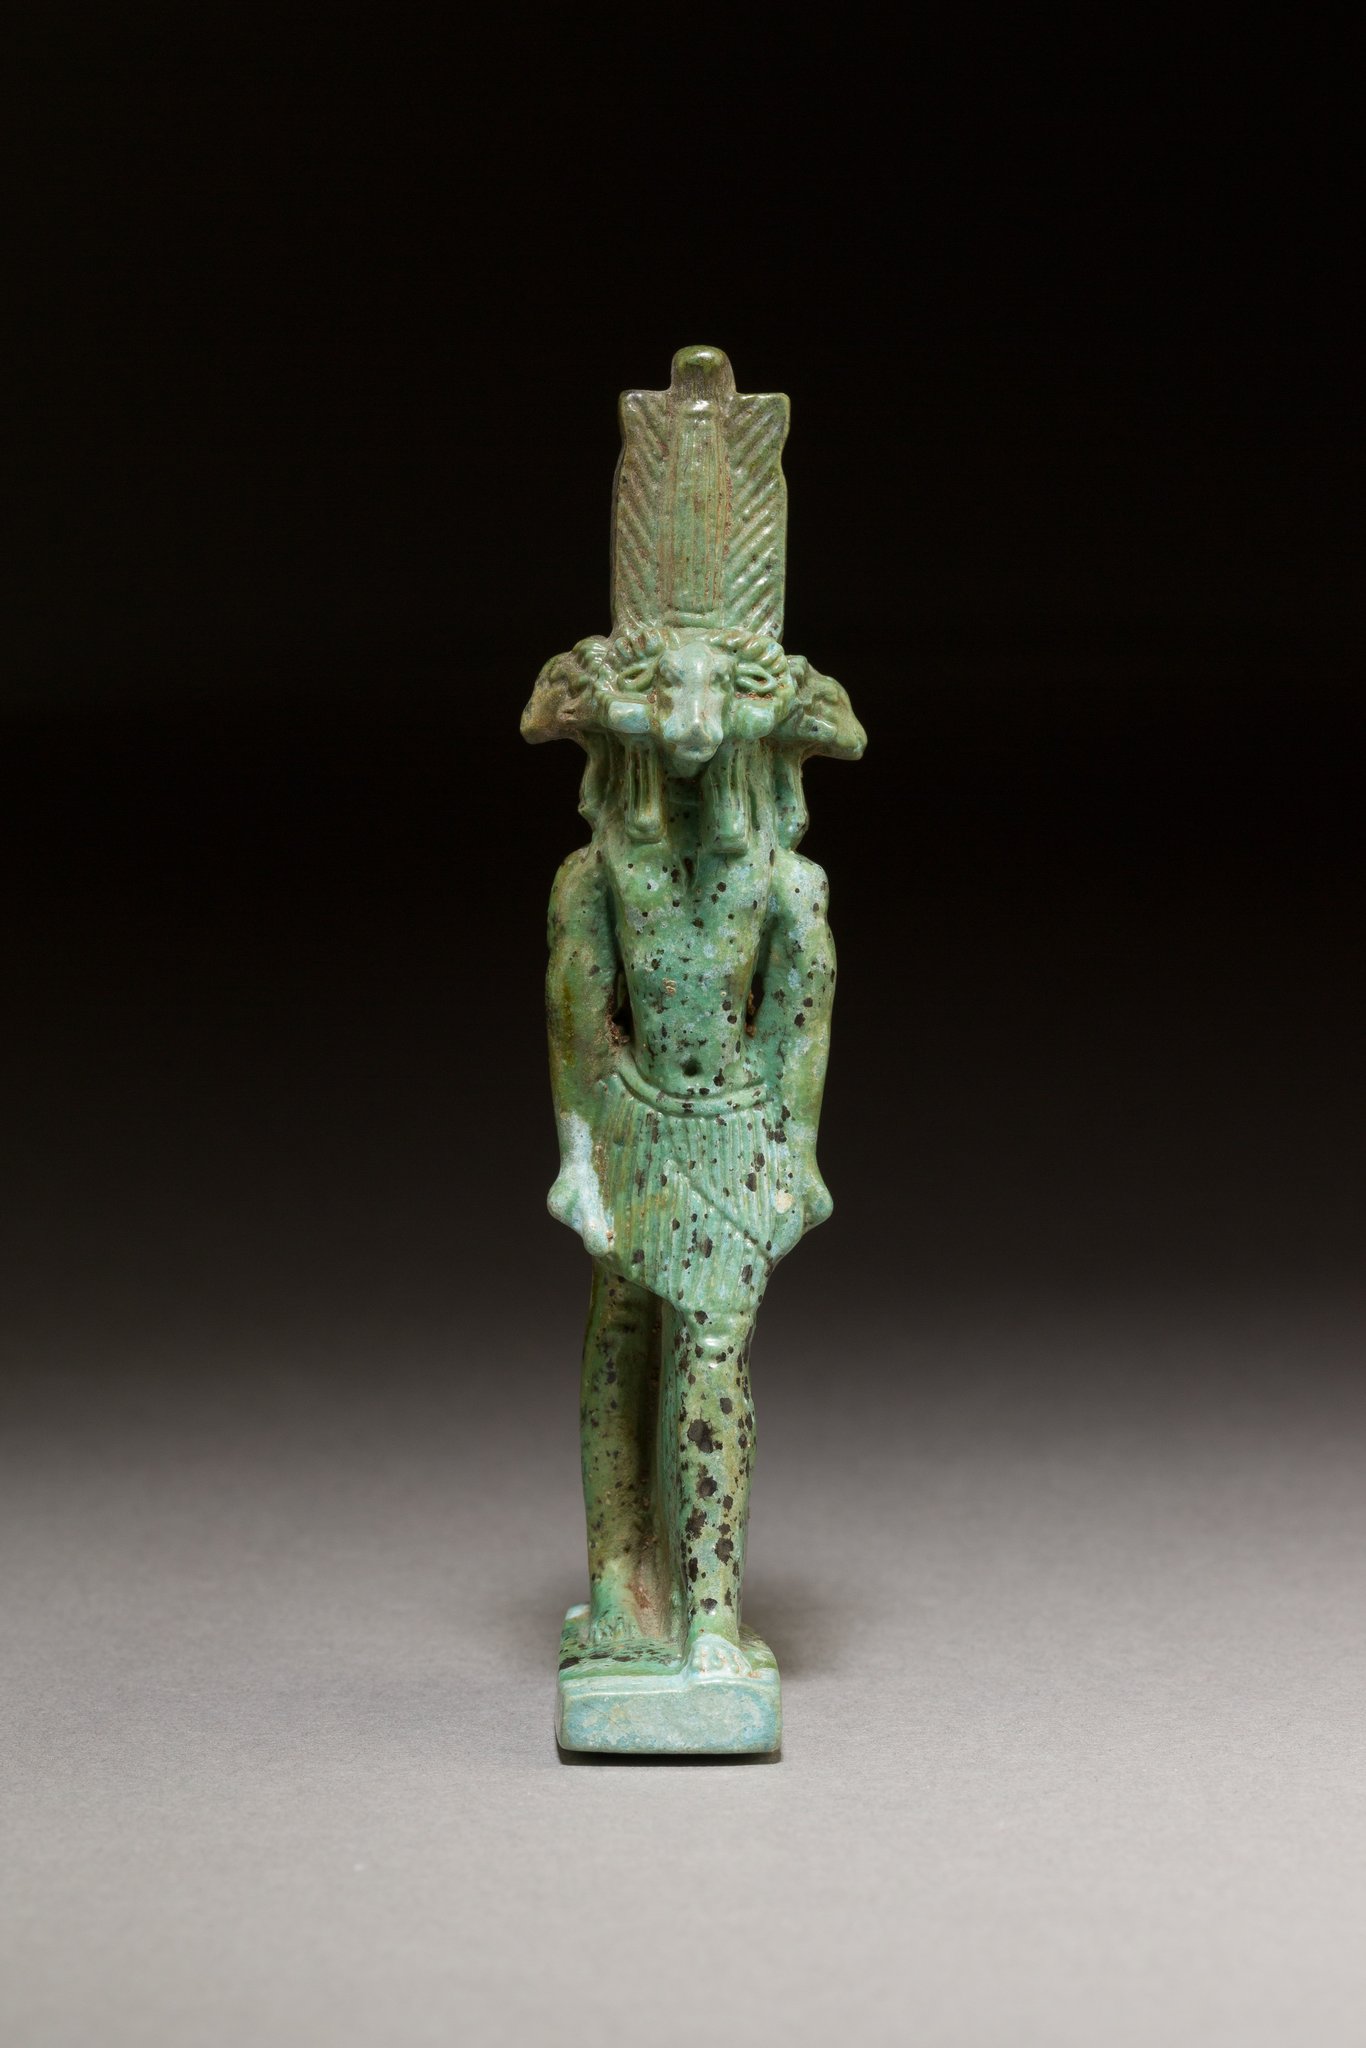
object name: amulet, khnum, ram, four headed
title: God with four ram heads facing in four directions, probably Khnum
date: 664-630 BCE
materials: faience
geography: egypt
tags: rams